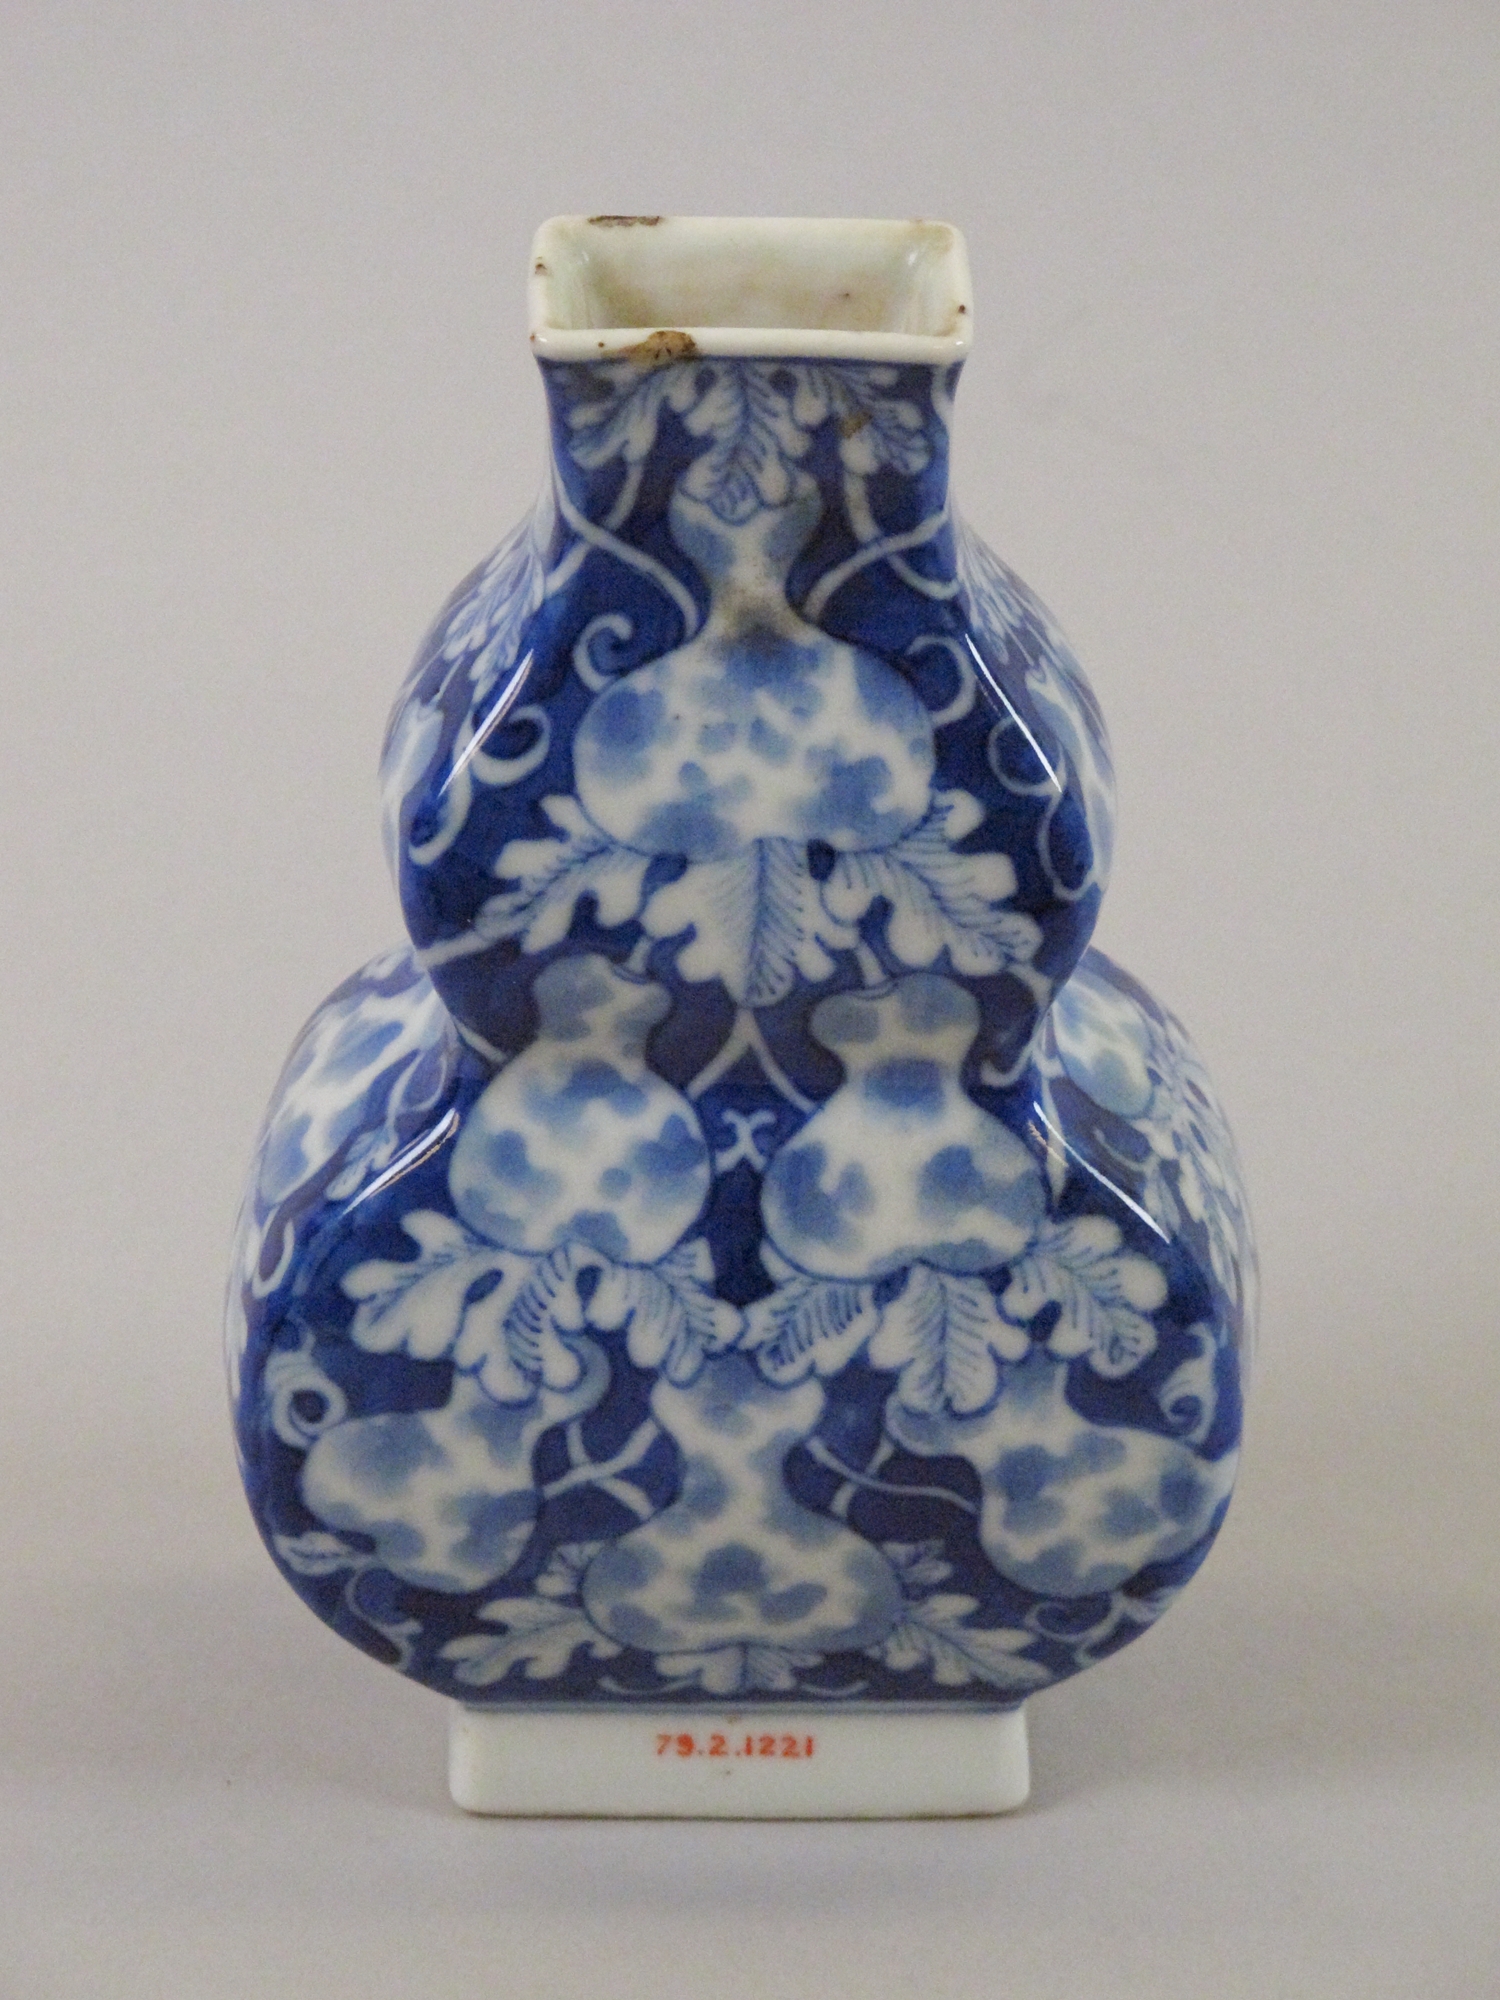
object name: vase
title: Double gourd vase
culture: chinese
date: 1801-1900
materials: cobalt, porcelain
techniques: painting, underglaze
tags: fruit,leaves